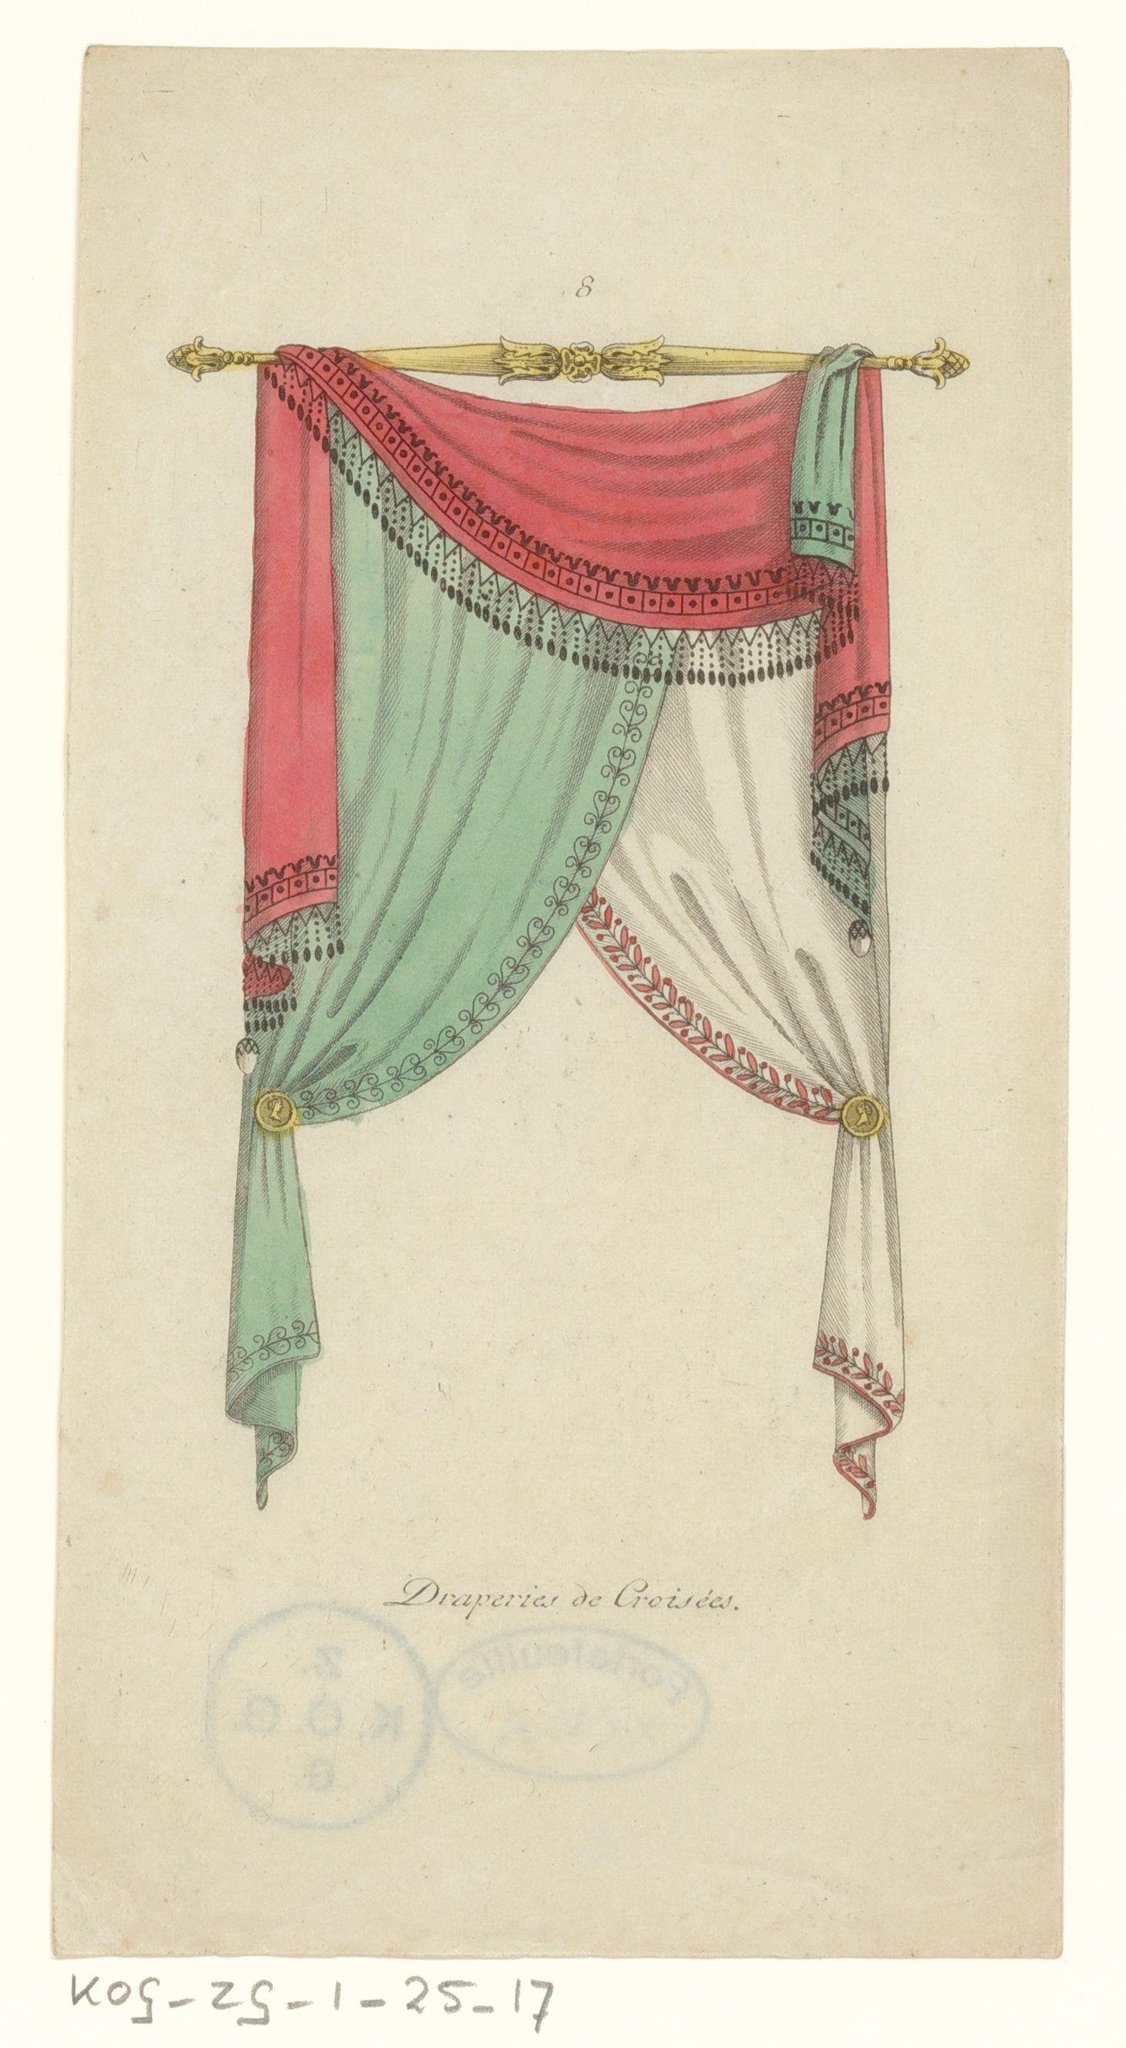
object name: print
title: Overslaand gordijn in Parijse stijl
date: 1807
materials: paper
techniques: engraving, hand coloring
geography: amsterdam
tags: curtains, decorative furniture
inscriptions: stamp, collector's mark: Lugt 1641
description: Bovenaan genummerd: 8. Onderwerpsrubrieken binnen de Atlas Zeden en Gewoonten: Zeden en Gewoonten in Engeren Zin, De Woning, Binnenhuizen, Kamerbetimmering.